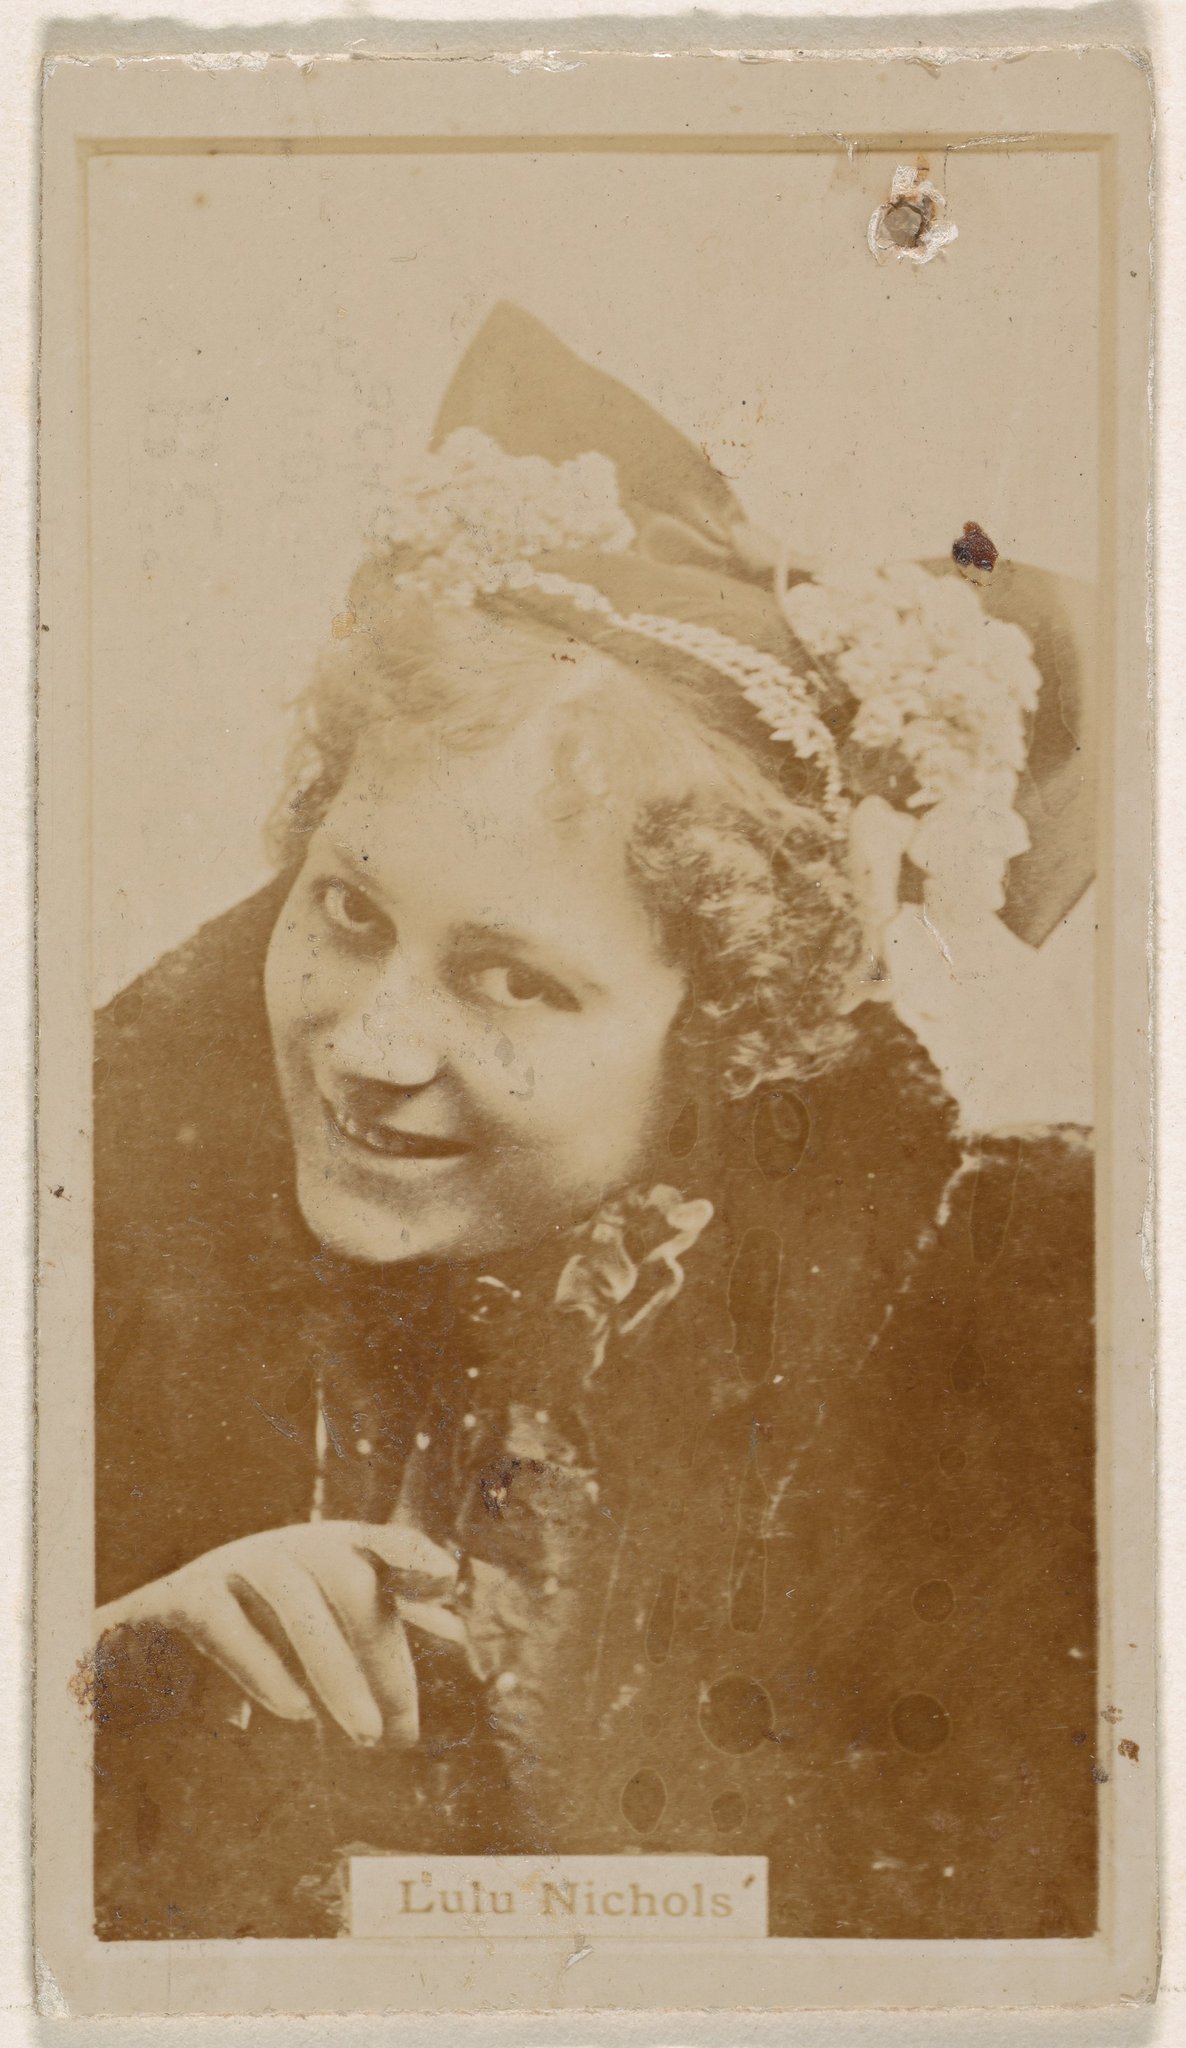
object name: photograph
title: Lulu Nichols, from the Actresses series (N245) issued by Kinney Brothers to promote Sweet Caporal Cigarettes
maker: kinney brothers tobacco company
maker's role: publisher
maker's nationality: american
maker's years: 1869-2011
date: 1890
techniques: albumen silver print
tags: portraits,women,actresses